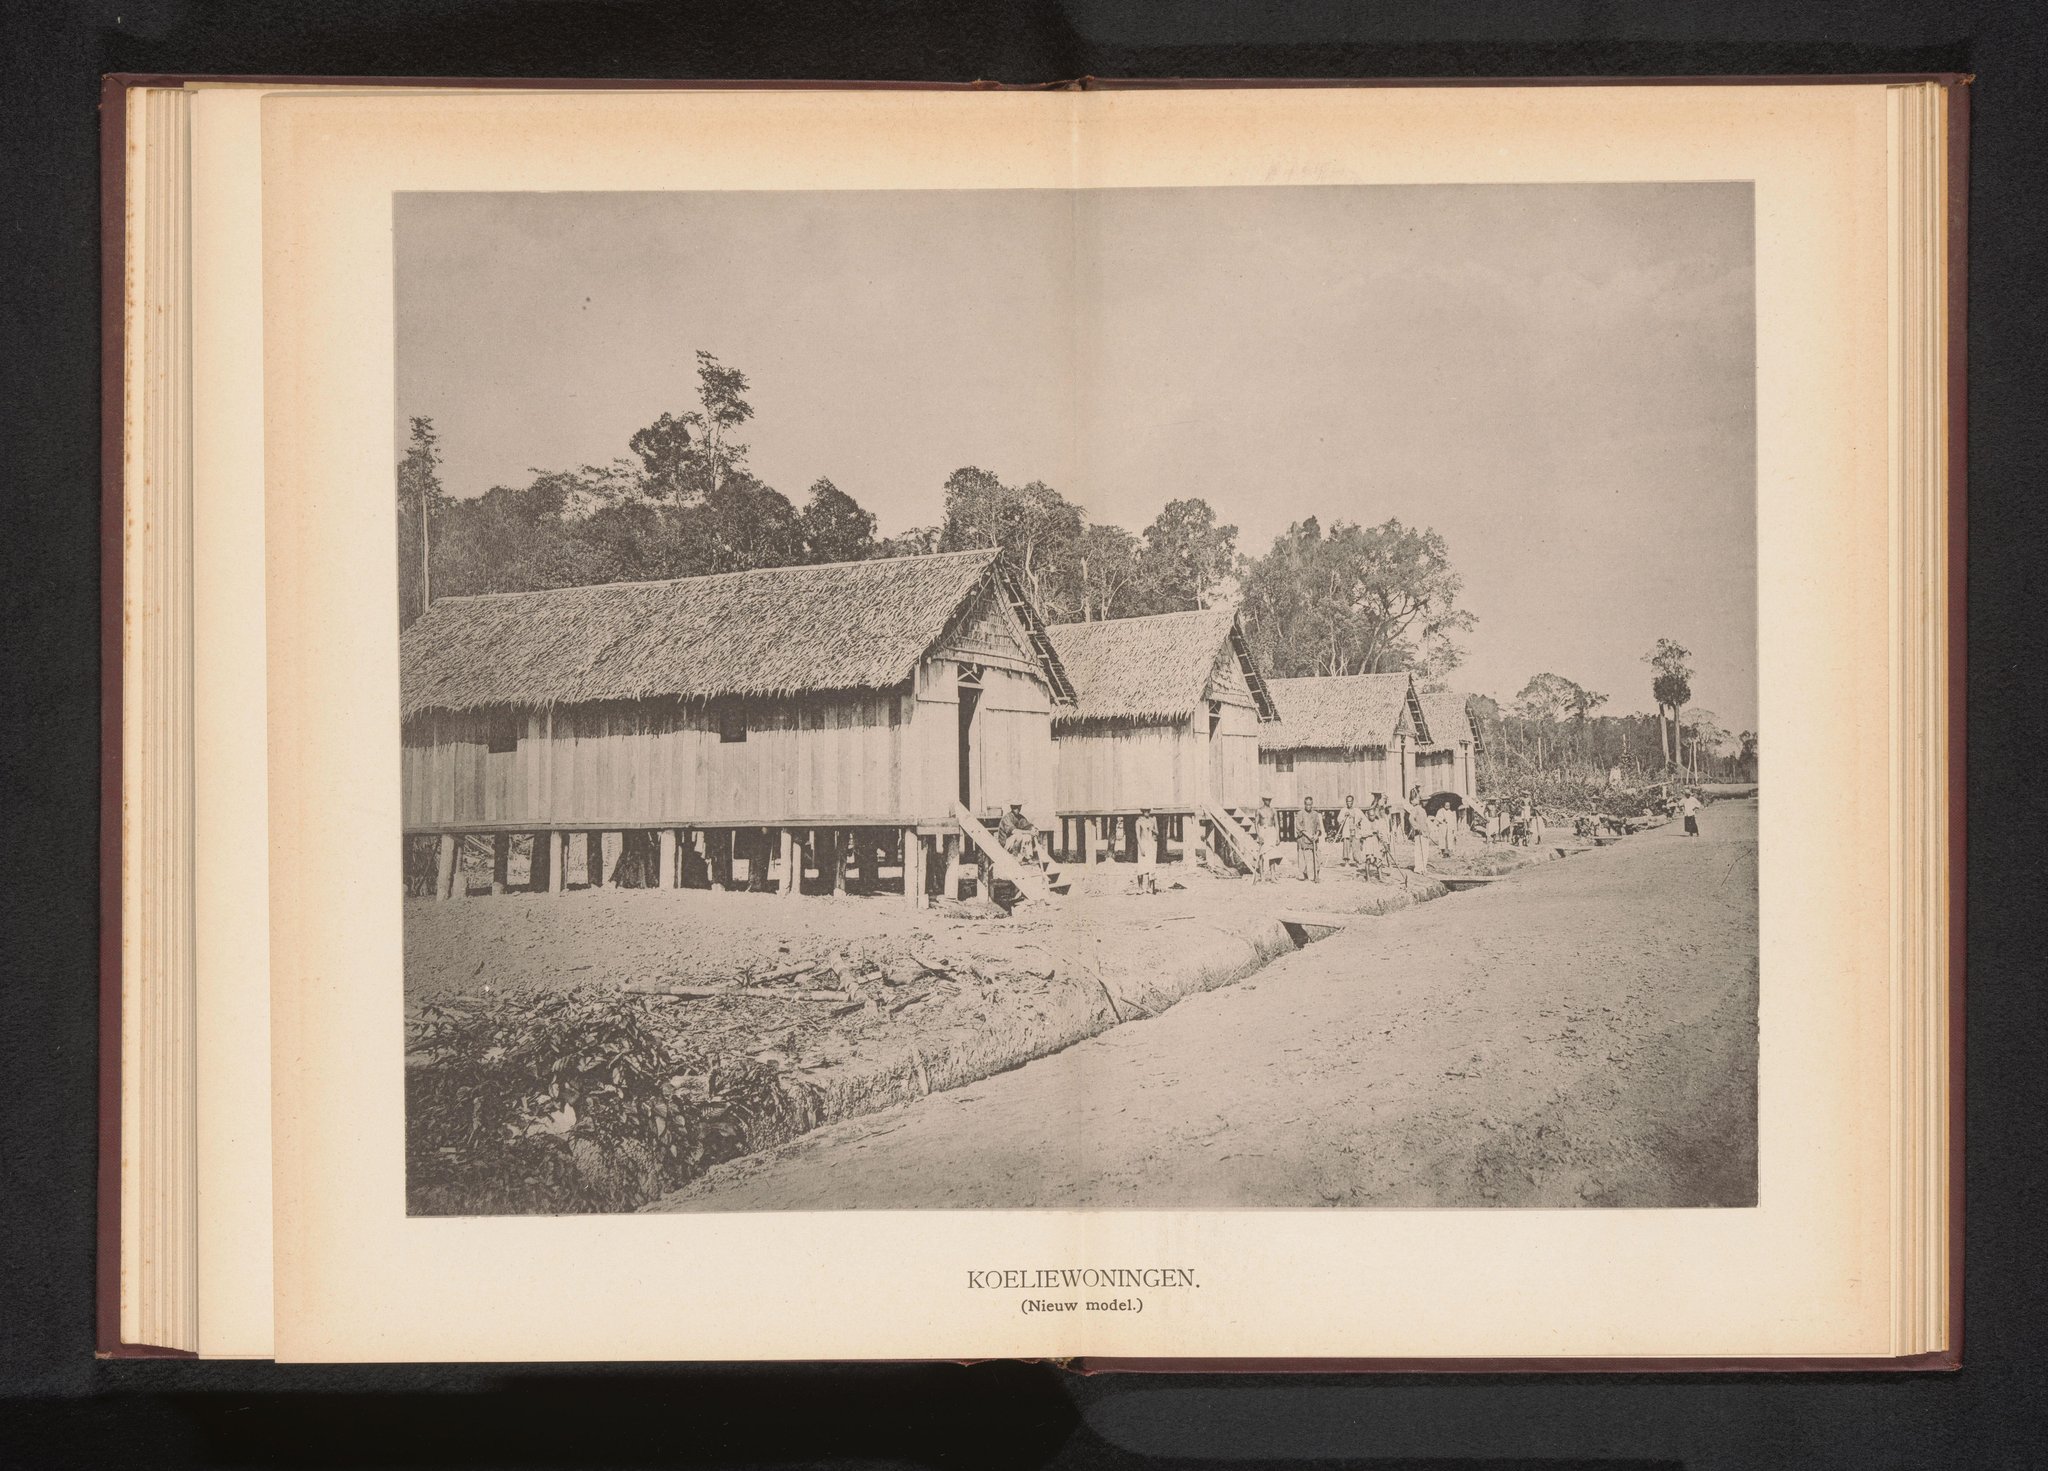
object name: photomechanical print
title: Arbeiderswoningen op een tabaksplantage in Deli, Sumatra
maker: Anonymous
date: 1884-1889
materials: paper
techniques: photograph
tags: plantation, working class, labourers, housing, tobacco, sumatra